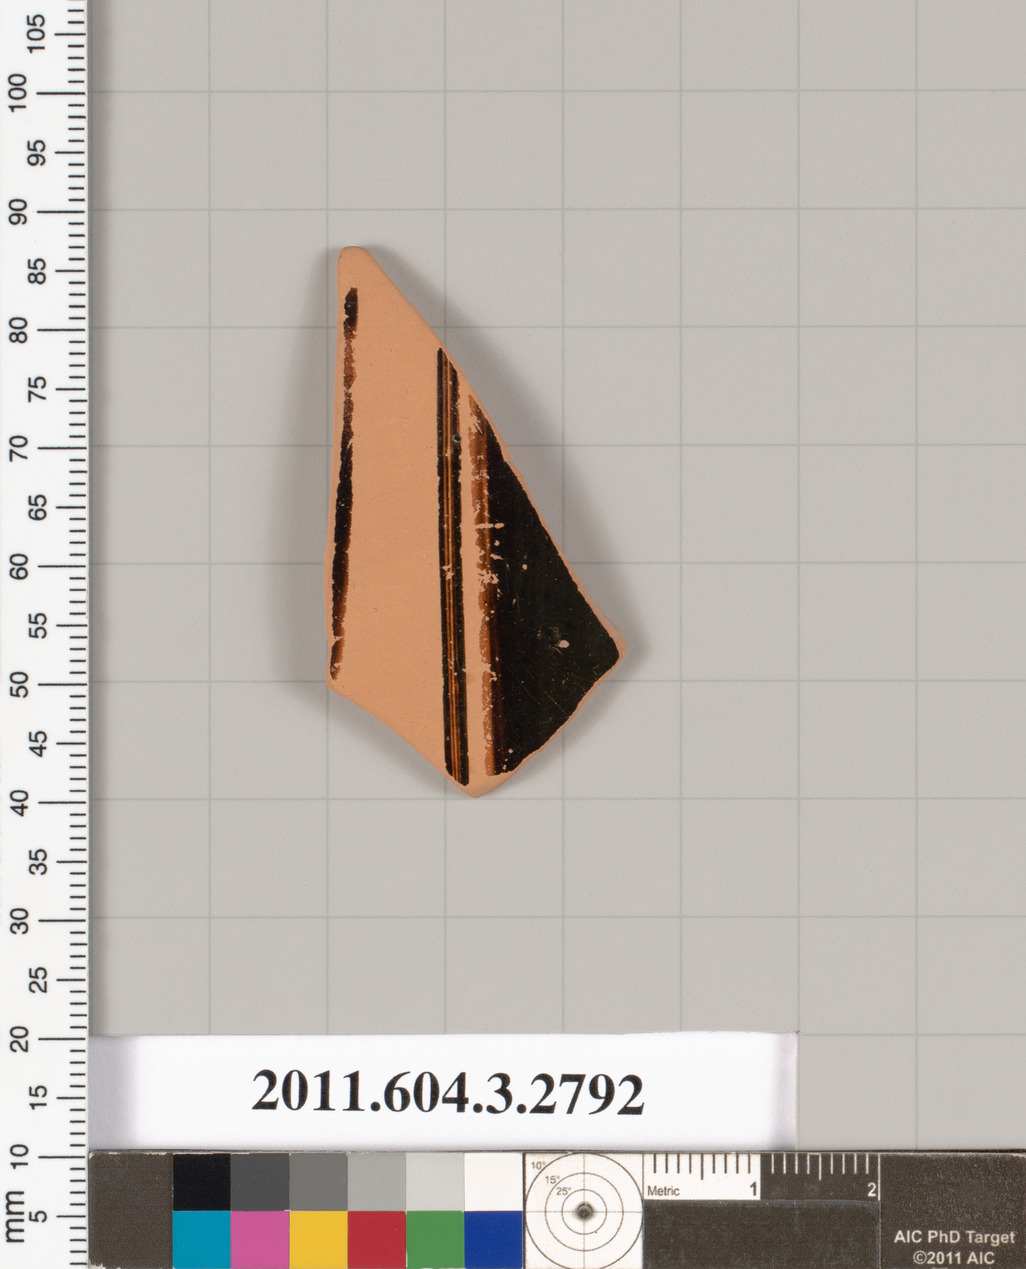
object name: oinochoe or olpe fragment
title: Terracotta fragment of an oinochoe (jug) or olpe (jug)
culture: greek, attic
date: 600-401 BCE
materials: terracotta